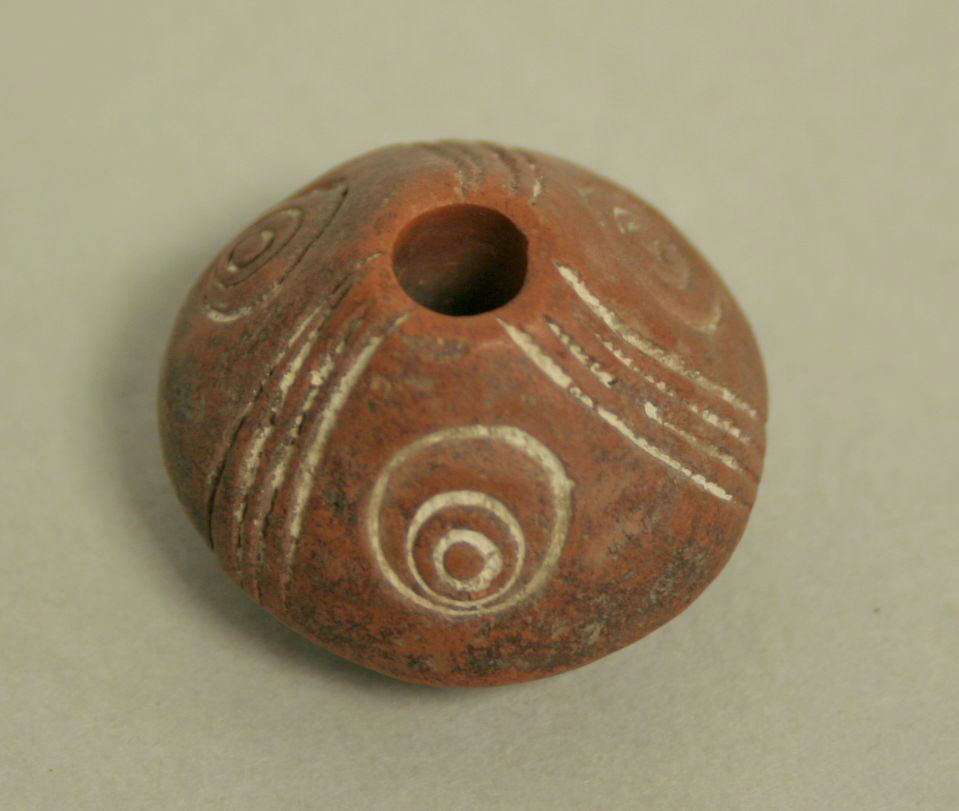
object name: spindle whorl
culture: peruvian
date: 1-500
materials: ceramic, pigment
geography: peru